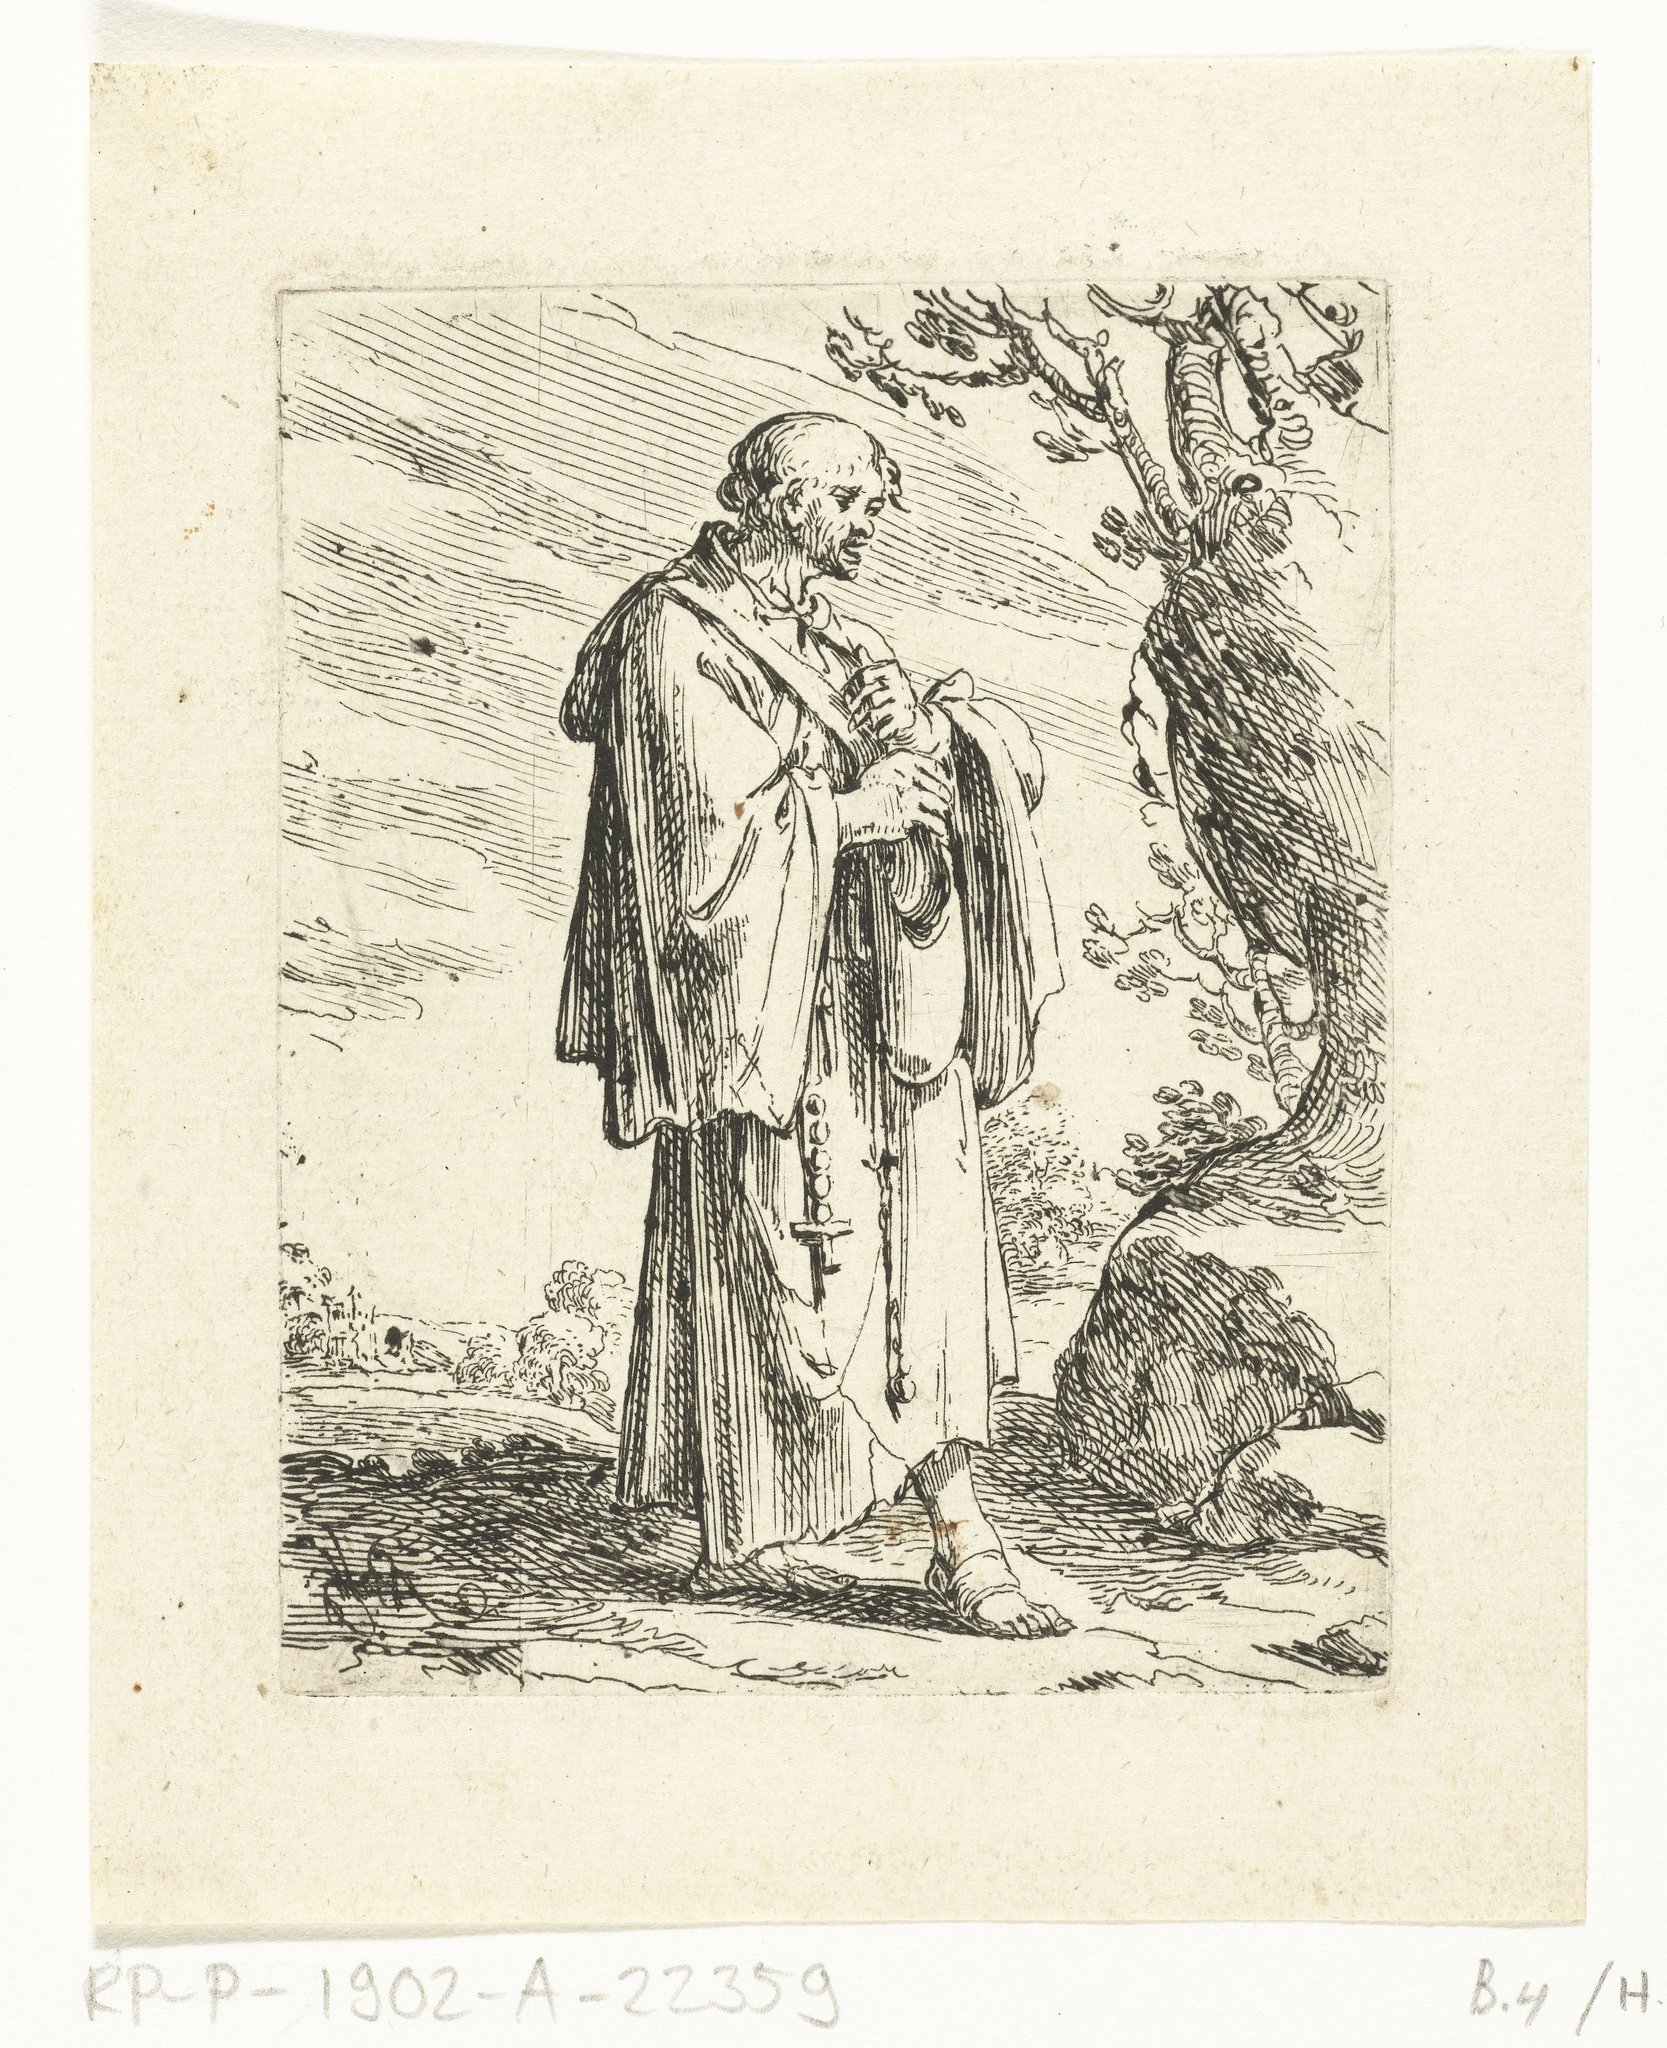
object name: print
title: Bedelmonnik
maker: andries both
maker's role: draughtsman, painter, print maker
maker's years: 1612-1642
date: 1622-1642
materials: paper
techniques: engraving, etching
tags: monk(s), friar(s), beggar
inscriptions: collector's mark: Lugt 2228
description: Een bedelmonnik, staand in een landschap.